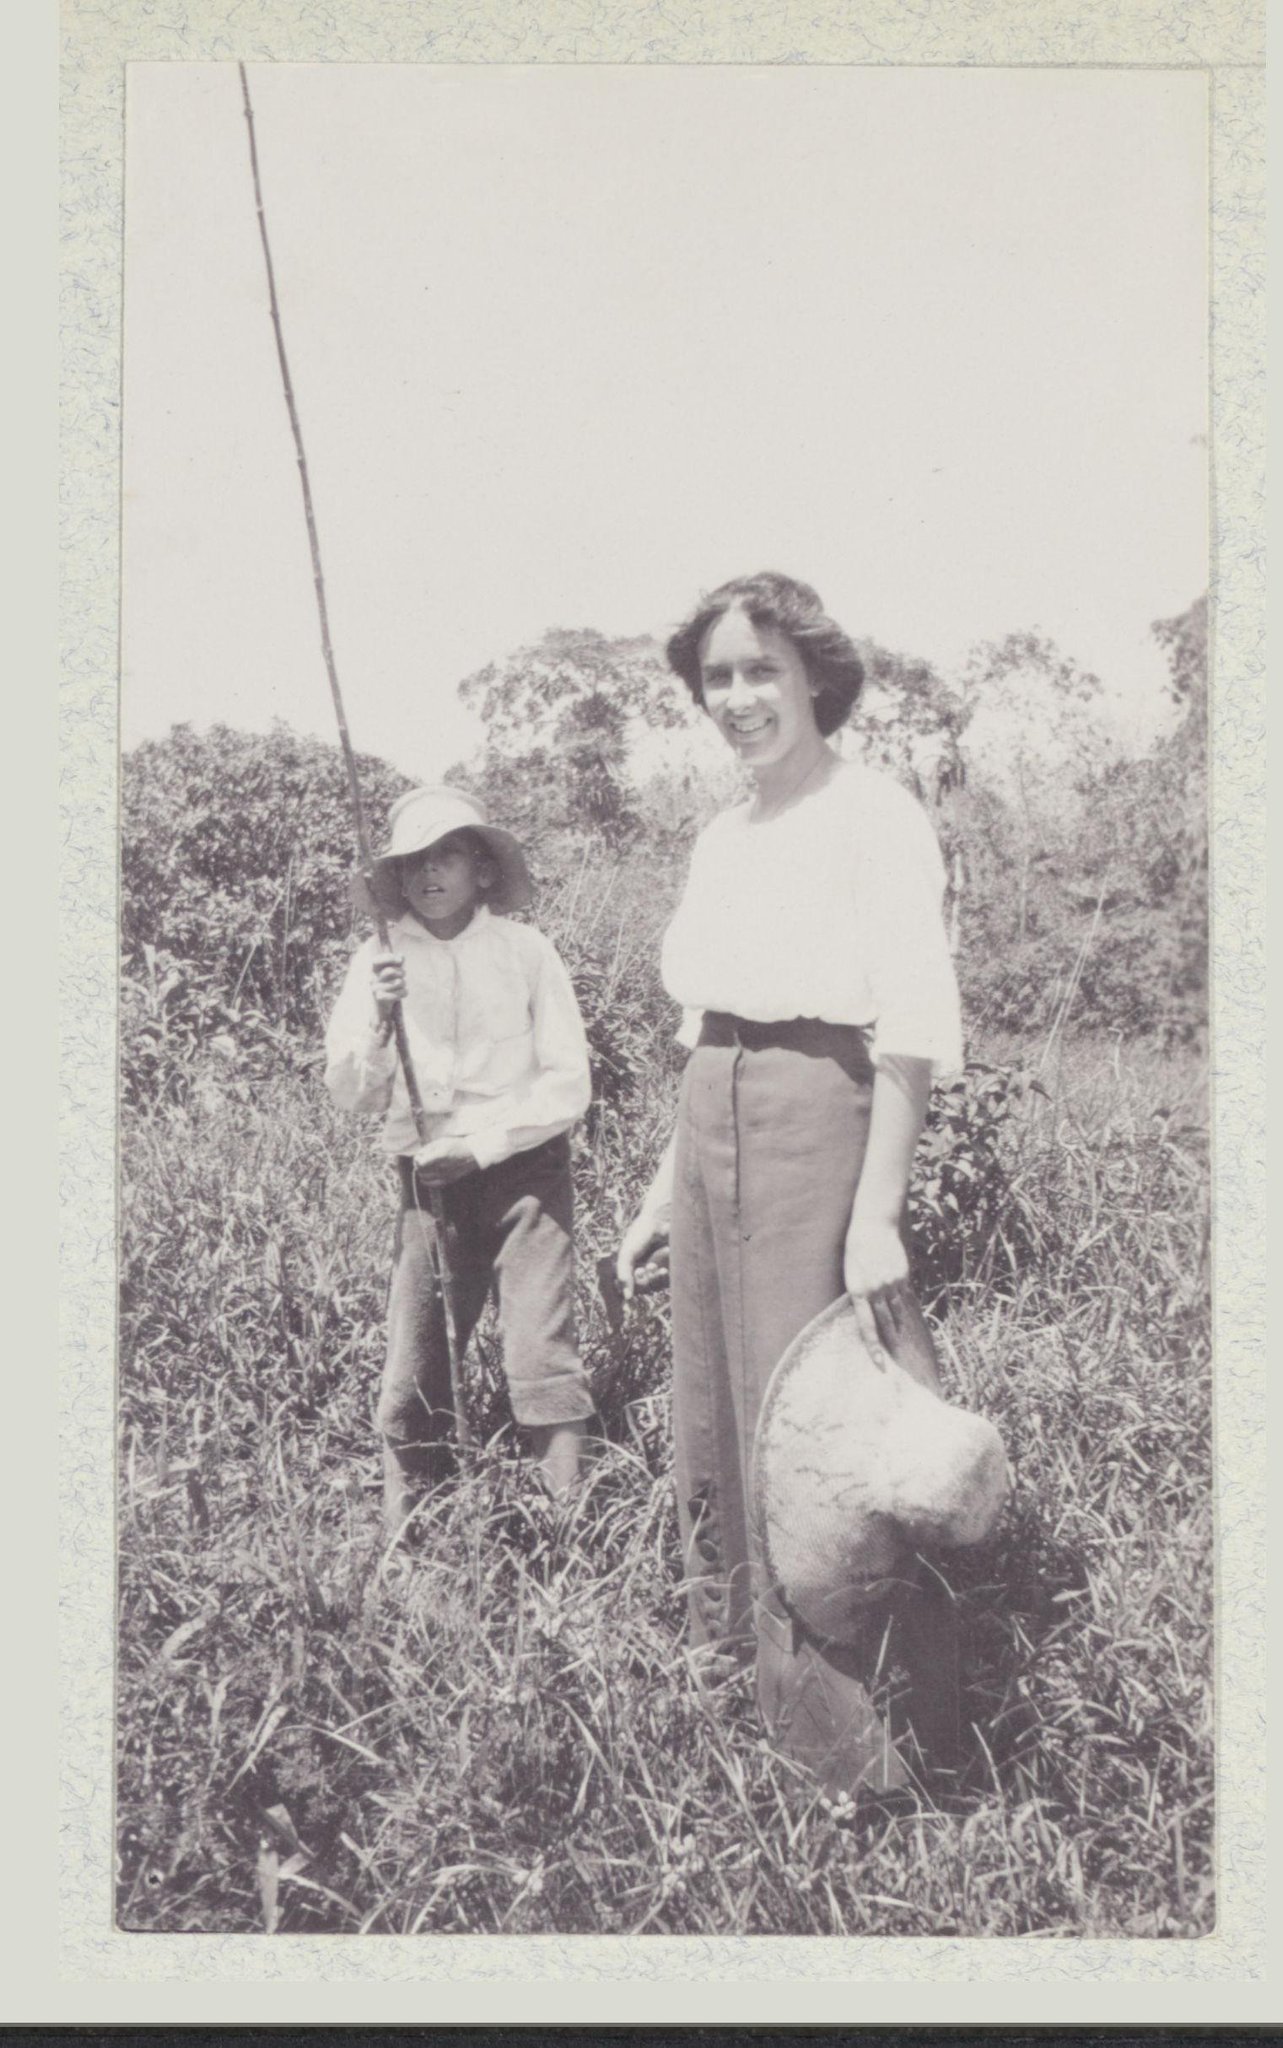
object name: photograph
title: Maria Gonggrijp, staand met de hoed in de hand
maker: andries augustus boom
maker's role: amateurfotograaf, handelaar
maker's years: 1878-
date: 1911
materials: photographic support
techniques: photography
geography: suriname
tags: suriname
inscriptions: inscription: ‘Clevia 1911’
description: Maria Gonggrijp, lachend en staand in het gras met de zonnehoed in de hand. Achter haar een jongen met een stok (hengel?). Op Plantage Clevia, 1911. Onderdeel van het fotoalbum van de familie Boom-Gonggrijp in Suriname en Curaçao.